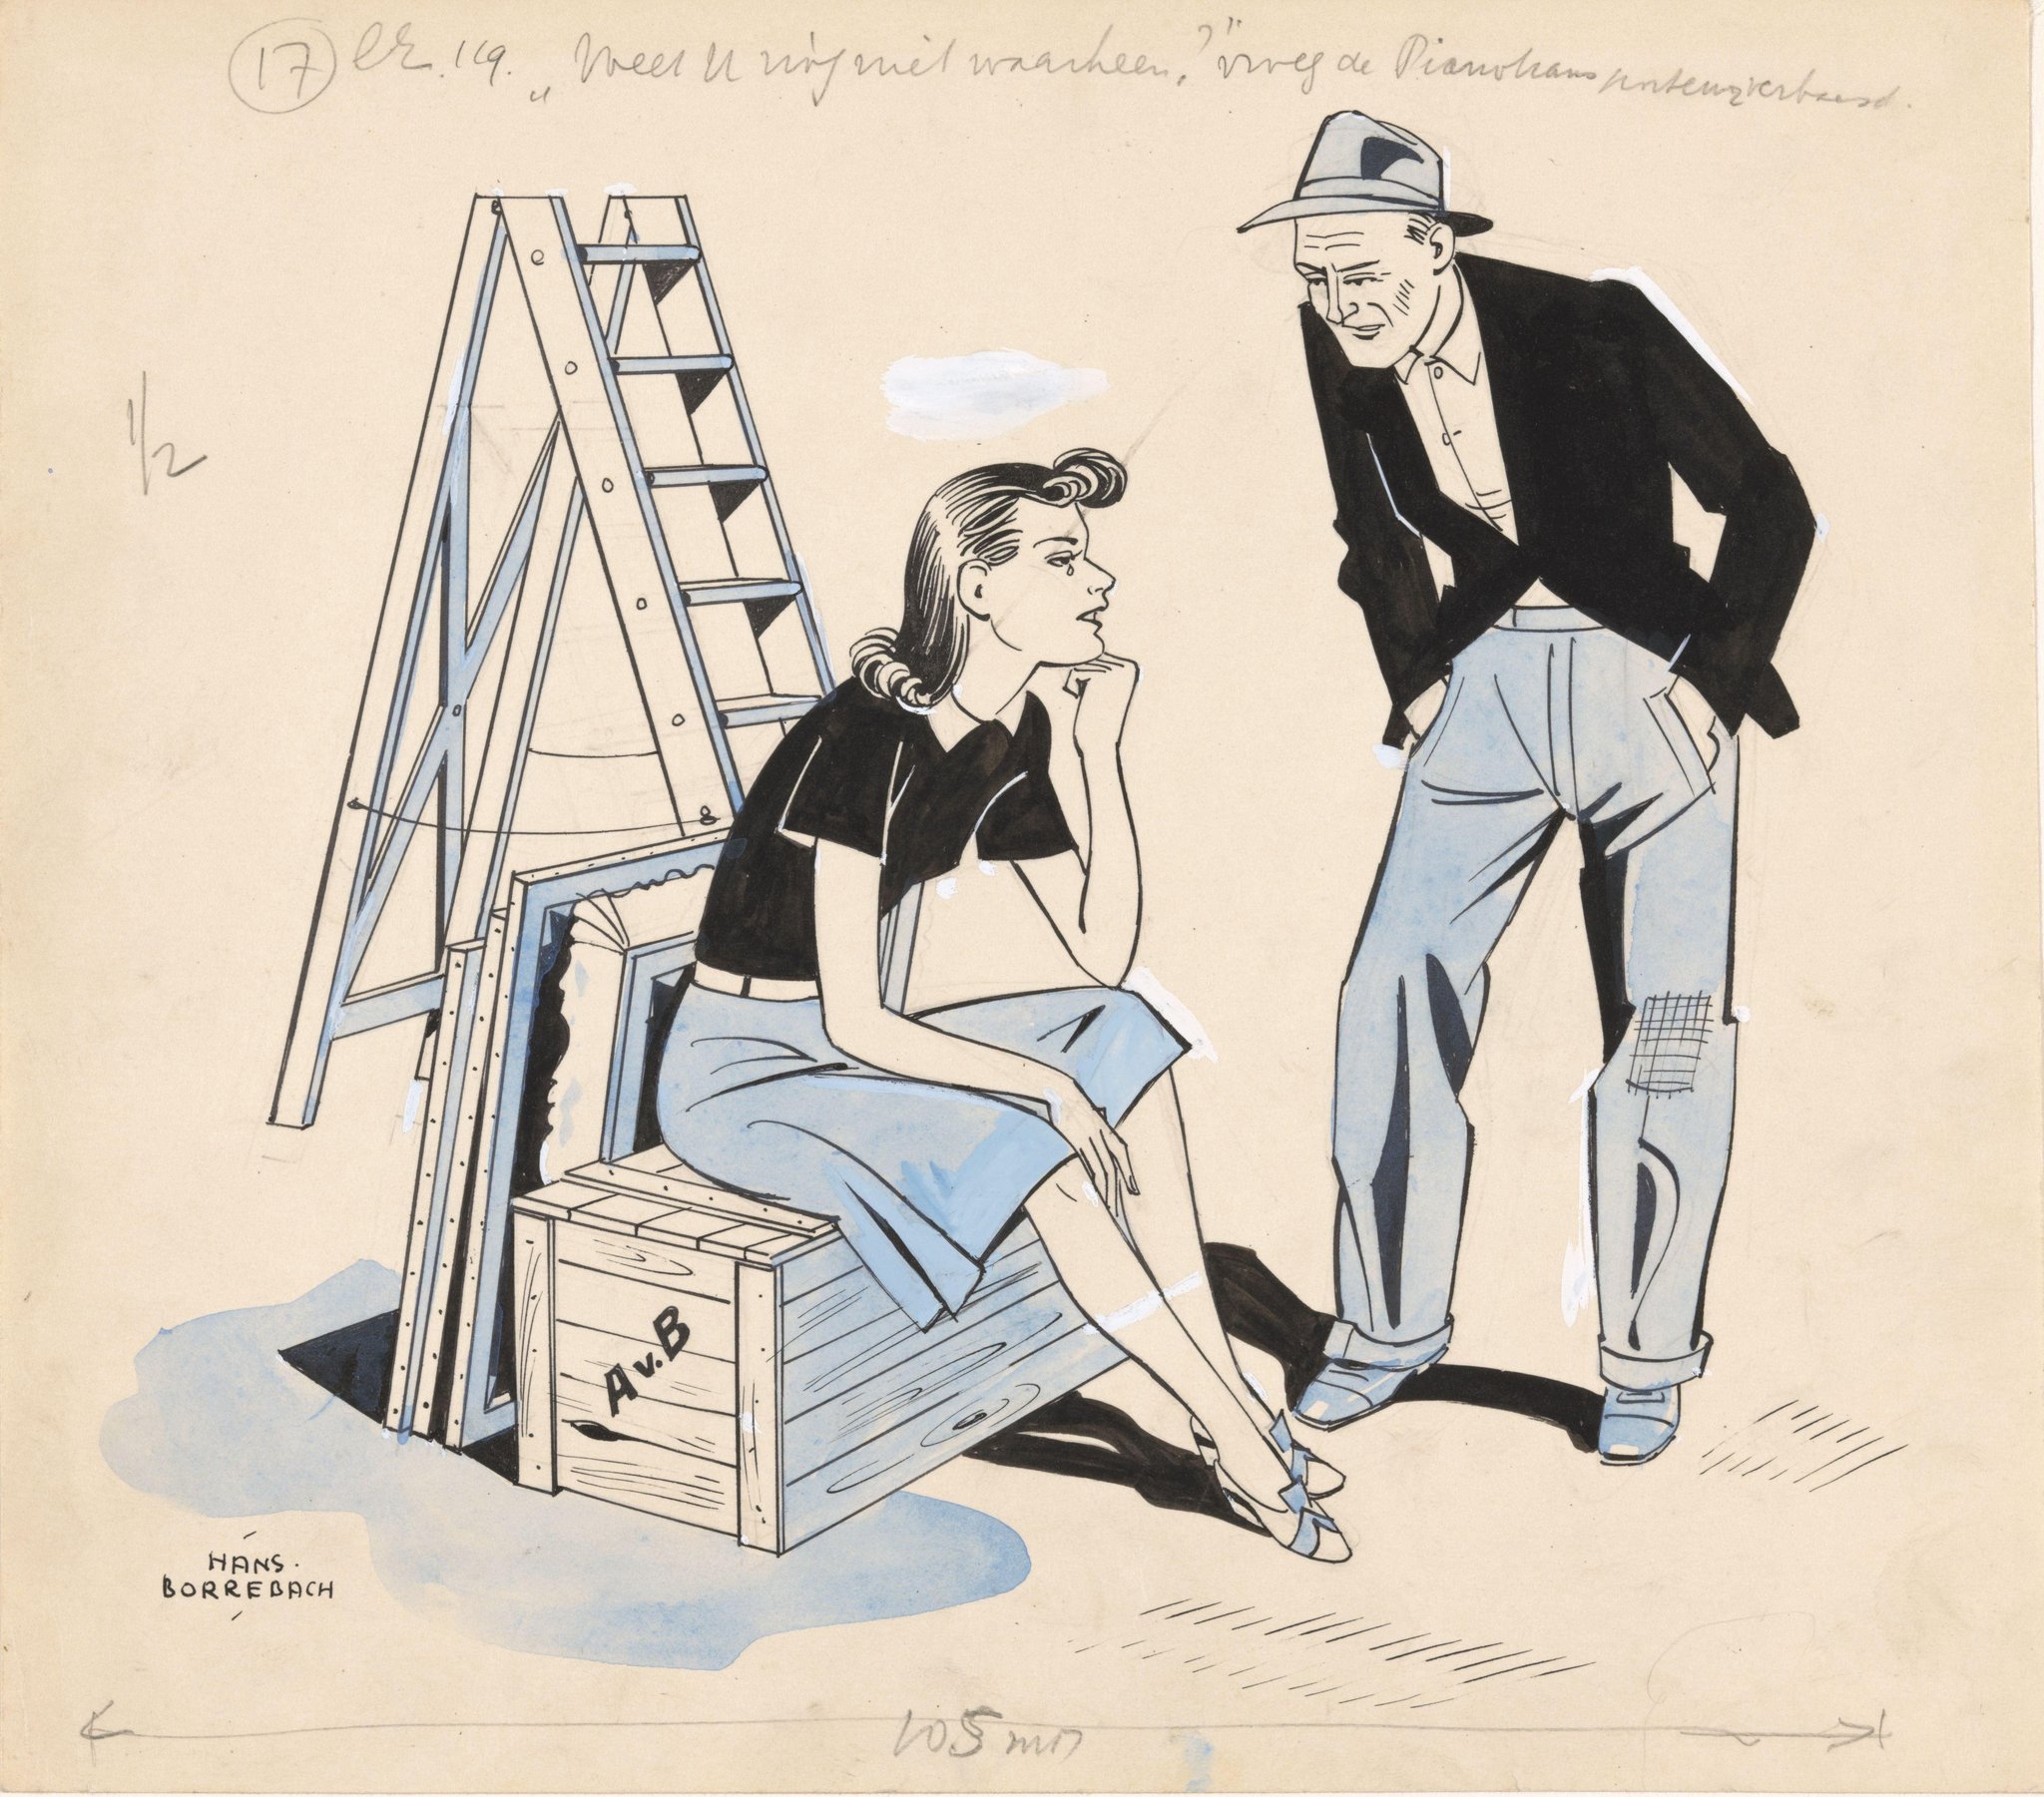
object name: boekillustratie ontwerp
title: Huilende Lony zittend op een houten krat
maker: hans borrebach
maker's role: draughtsman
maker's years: 1903-1991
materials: paint, ink, paper, pencil, watercolor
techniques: brush, pen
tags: sitting figure - aa - female human figure, weeping, ladder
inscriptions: collector's mark: Lugt 2228a, :, signature: ‘HANS./ BORREBACH’, annotation: ‘17 bz 119. "Weet U nog niet waarheen?" vroeg de Piano[...]ans[...]teur verbaasd.’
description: Lony zit met een betraand gezicht op een houten krat waartegen schilderijlijsten staan. Een staande man met een hoed en met beide handen in de zakken buigt zich naar Lony toe. Op de achtergrond staat een trap.